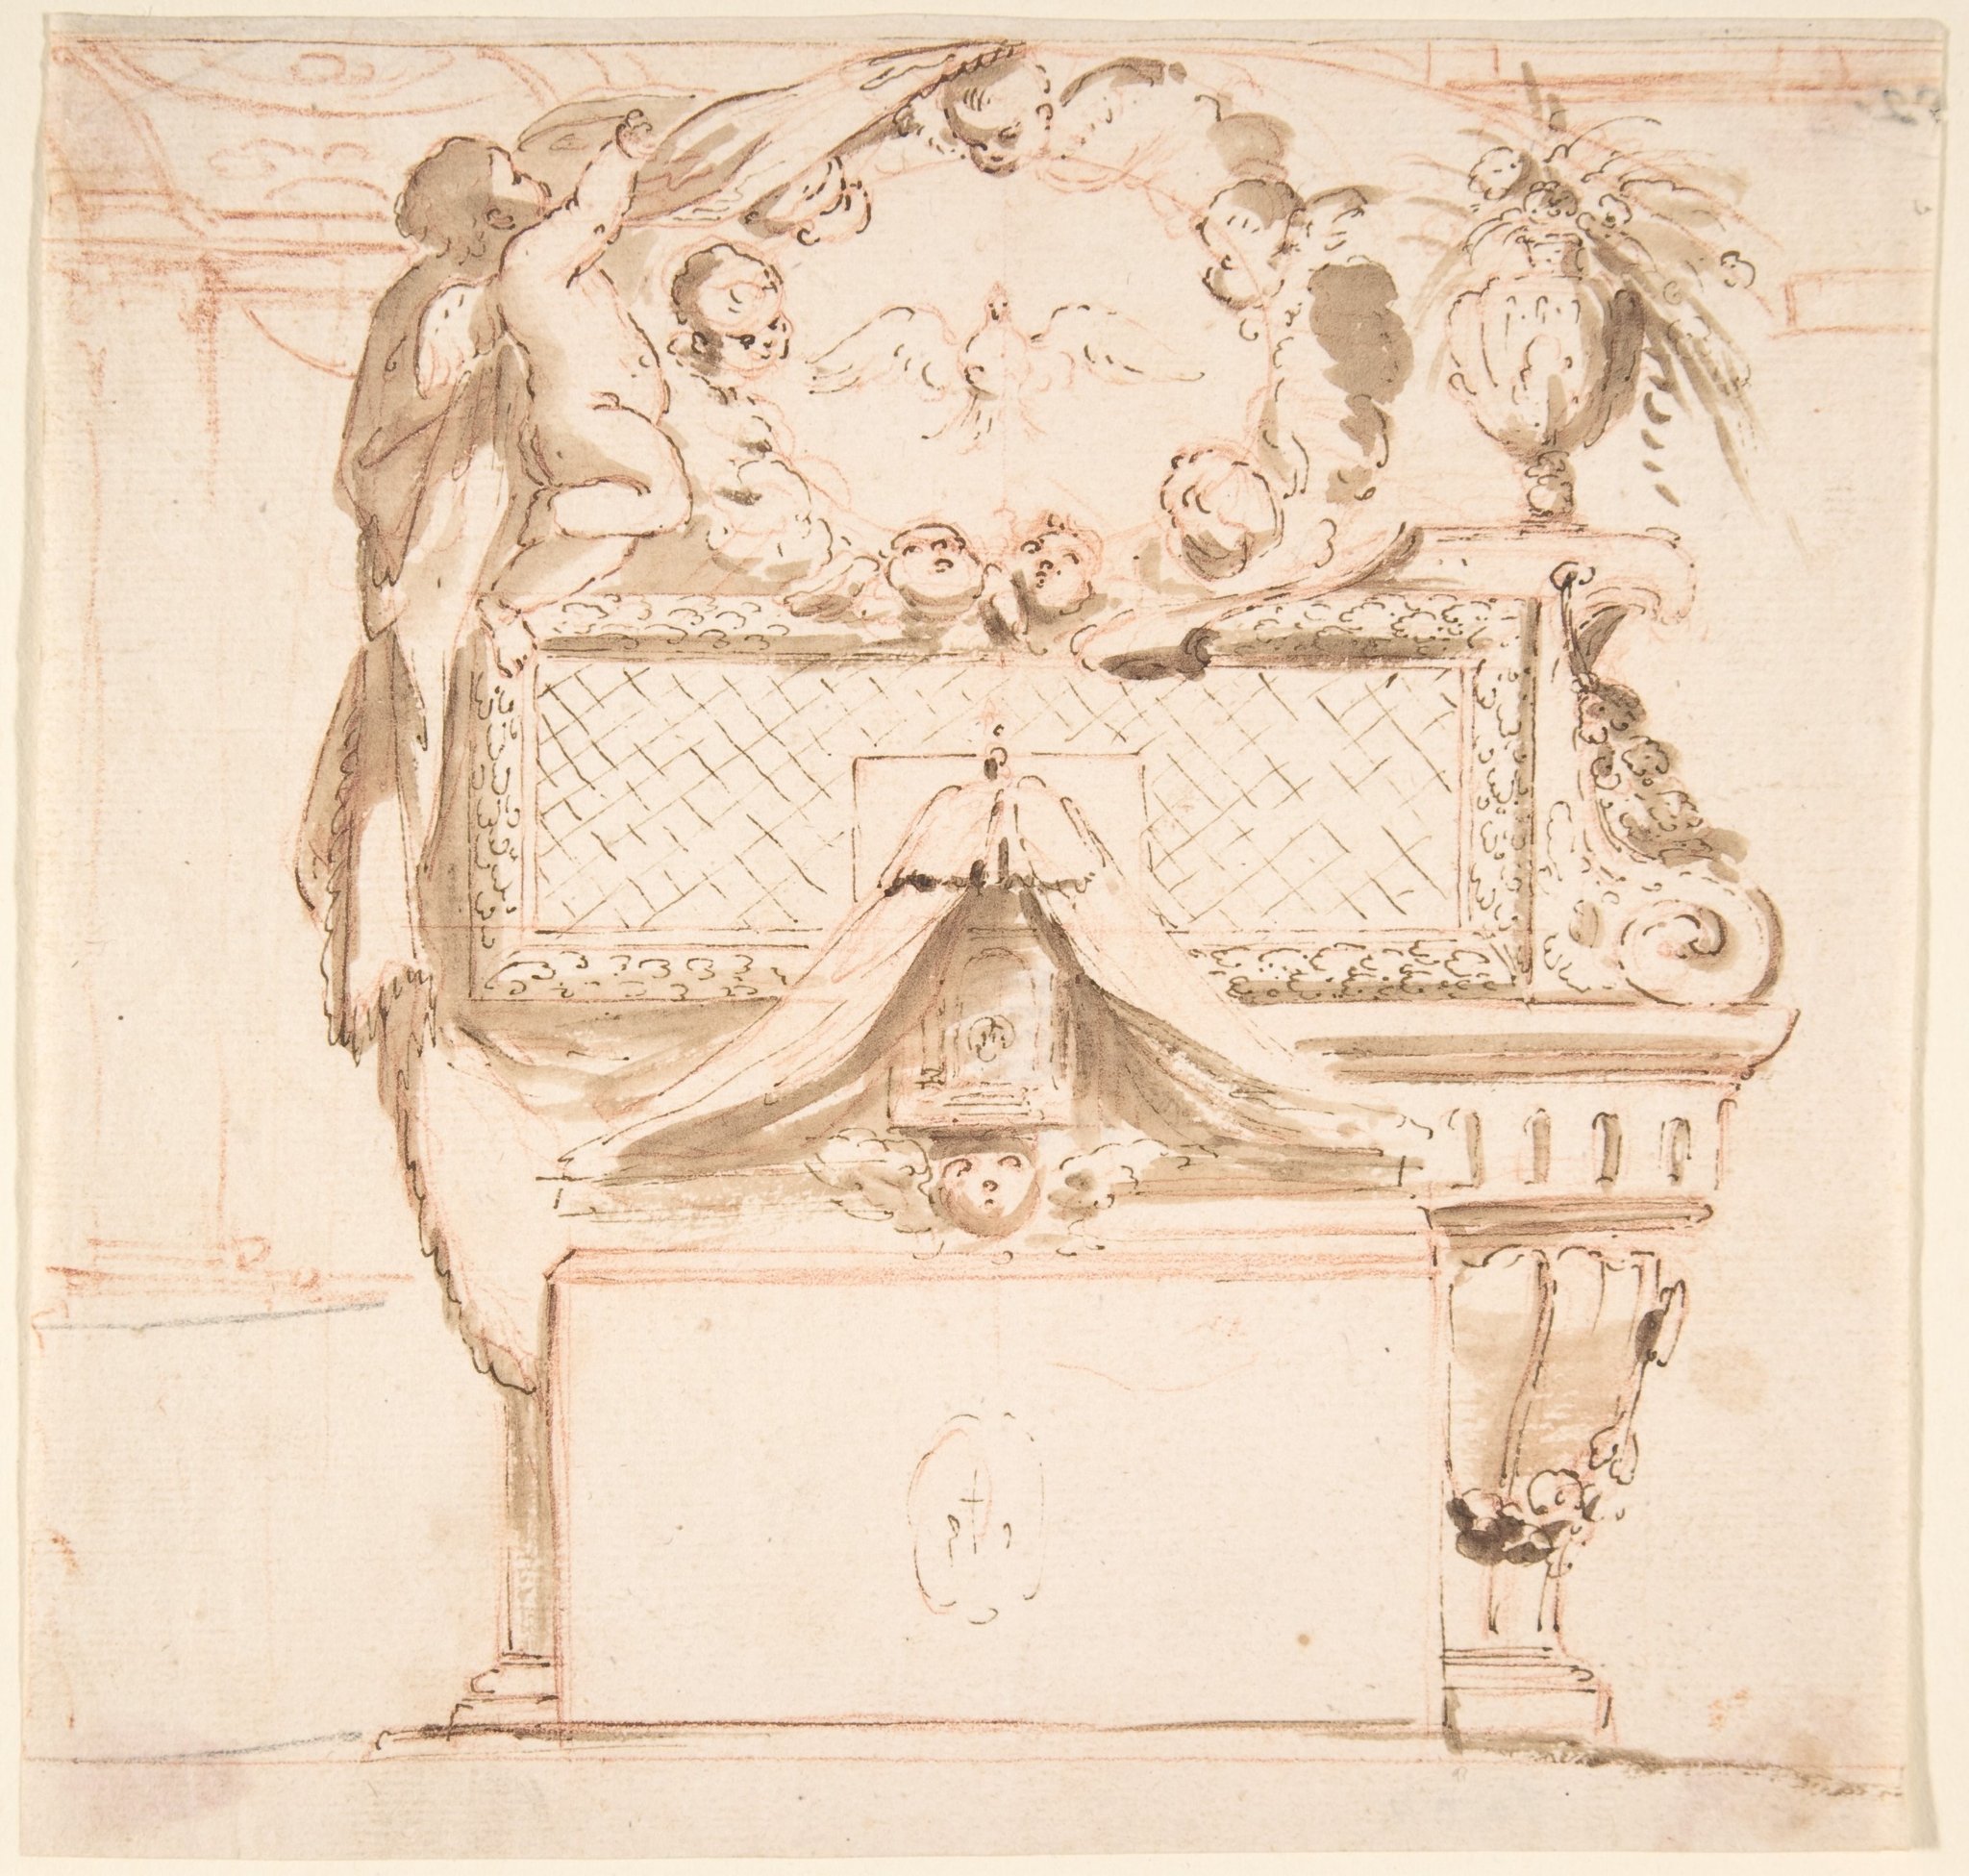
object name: drawing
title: Wall Tomb with Putti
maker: anonymous, italian, 17th century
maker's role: artist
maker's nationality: italian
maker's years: 1600-1700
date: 1601-1700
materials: chalk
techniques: brush, wash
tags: tombs